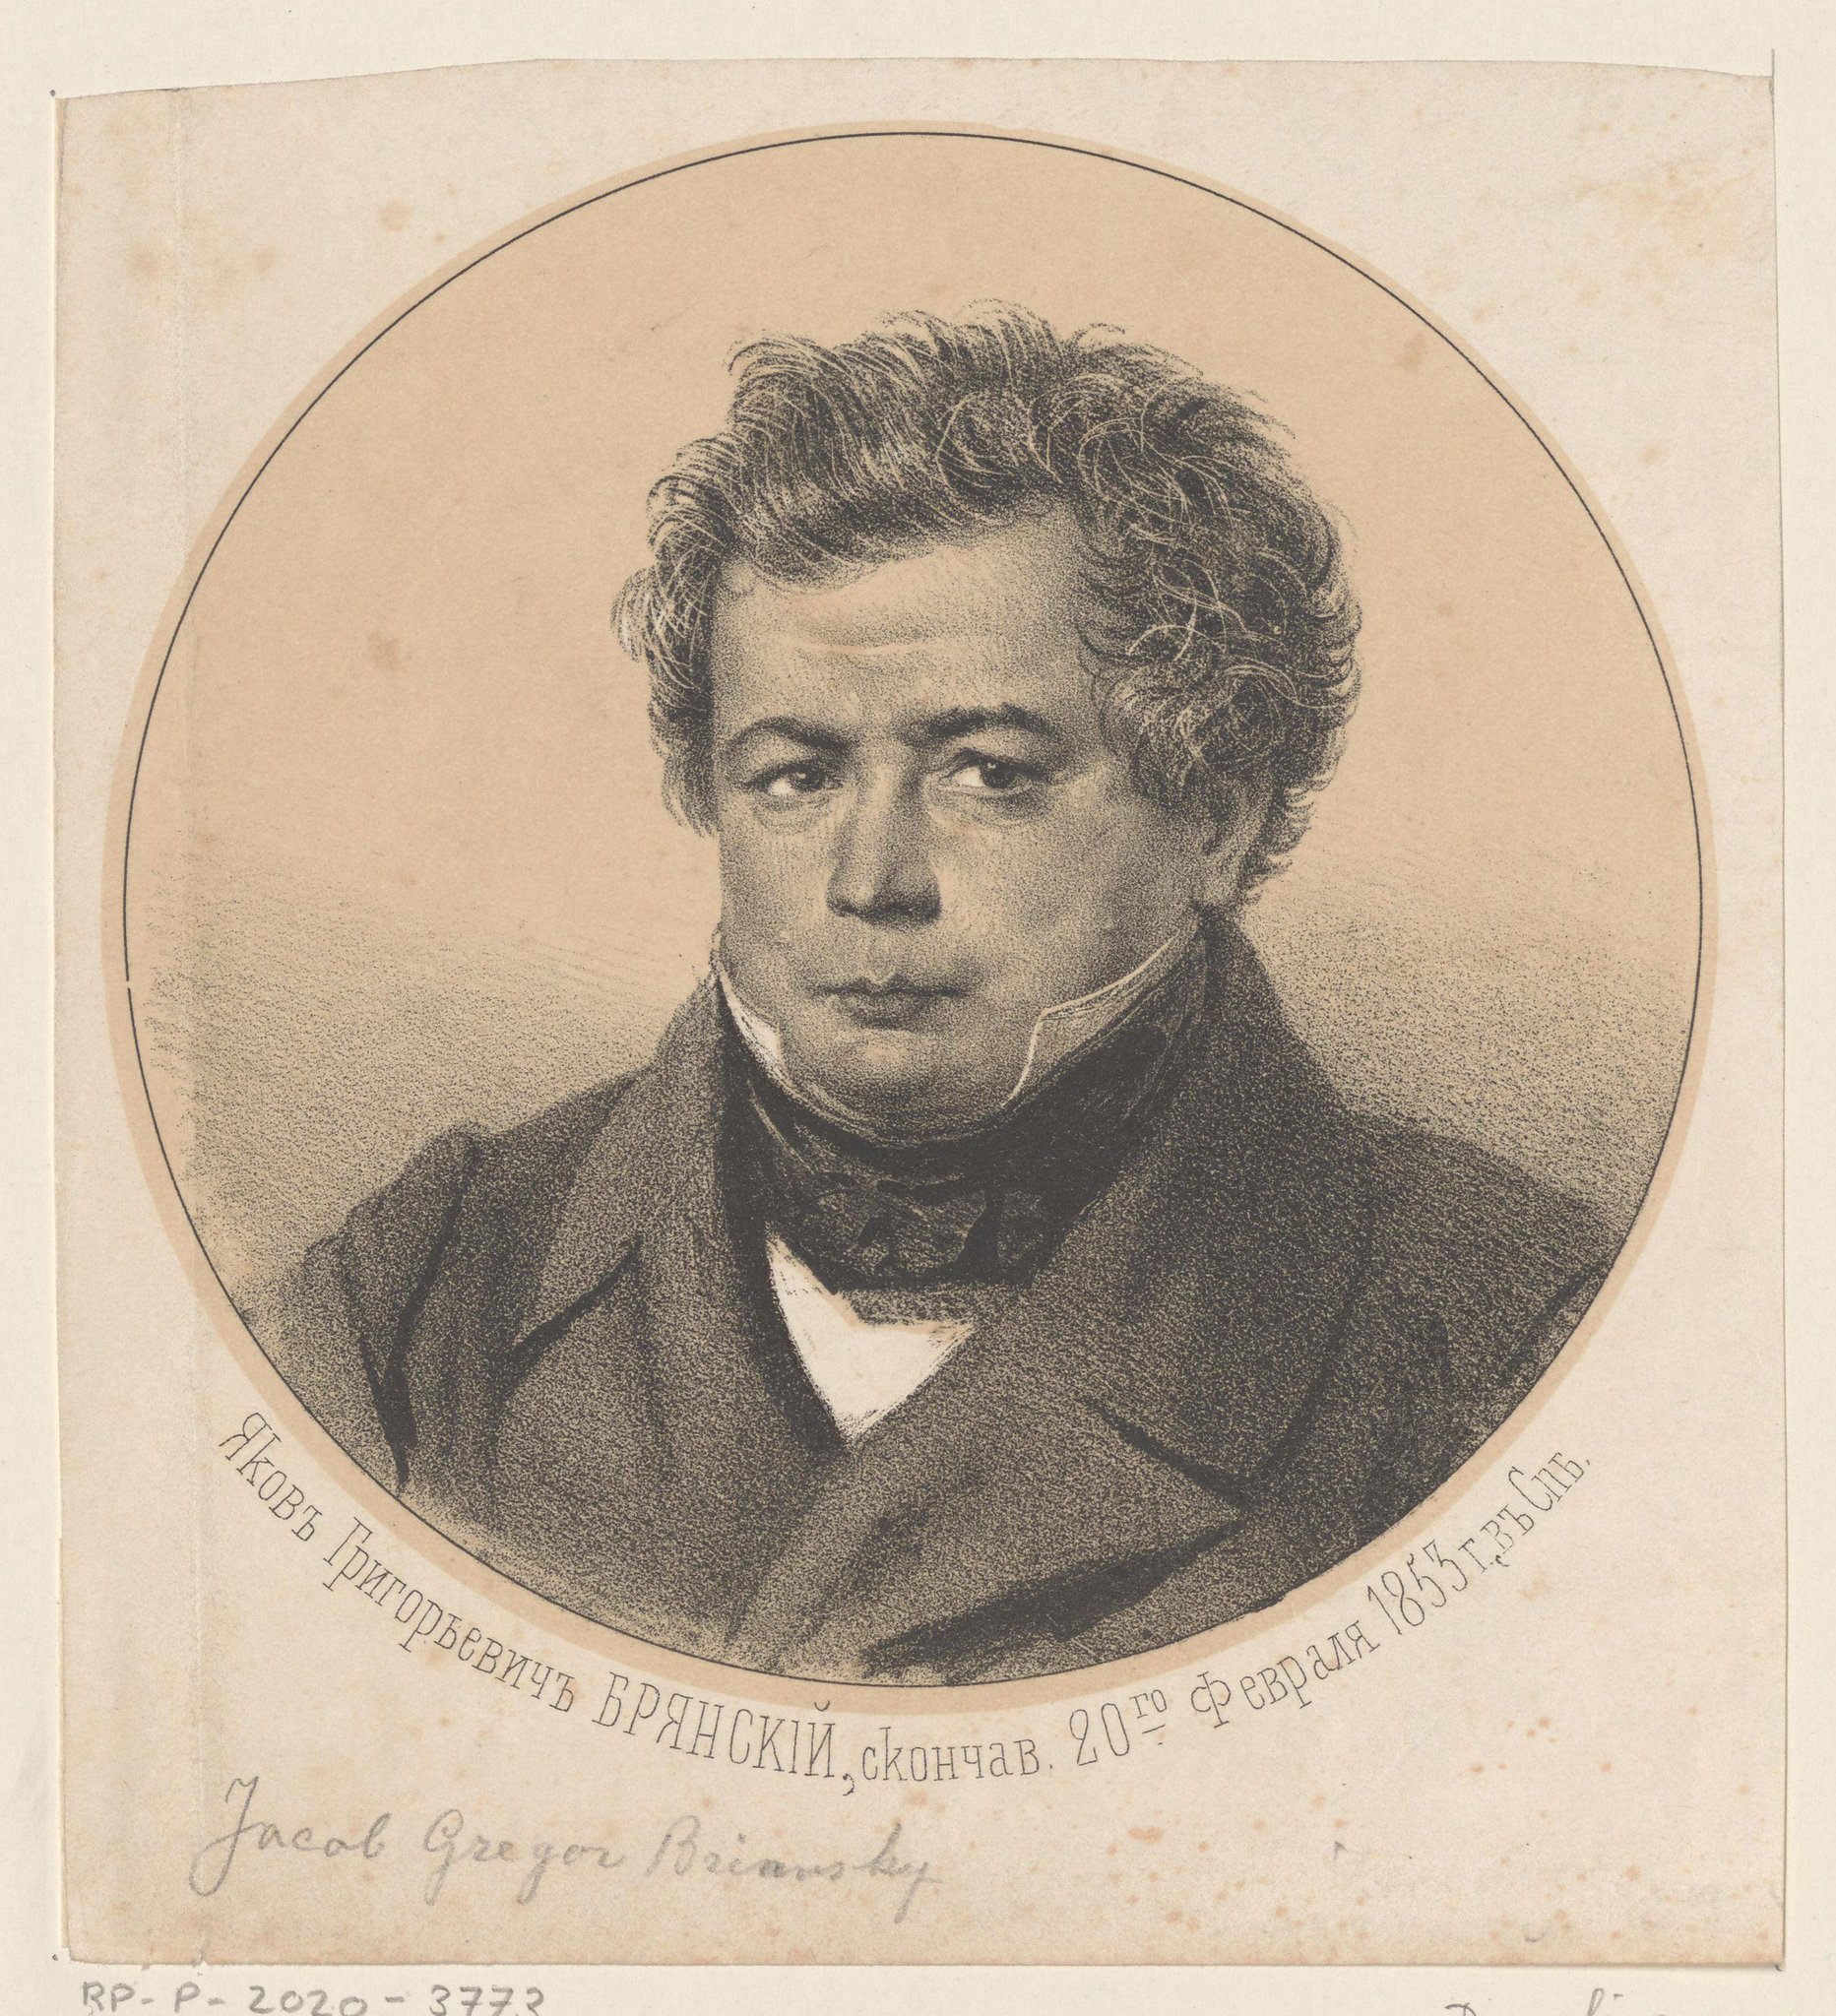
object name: print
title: Portret van Jakov Grigorjevitsj Brjanski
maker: Anonymous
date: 1853-1875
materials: paper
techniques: intaglio, lithograph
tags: historical persons, portrait of actor, actress